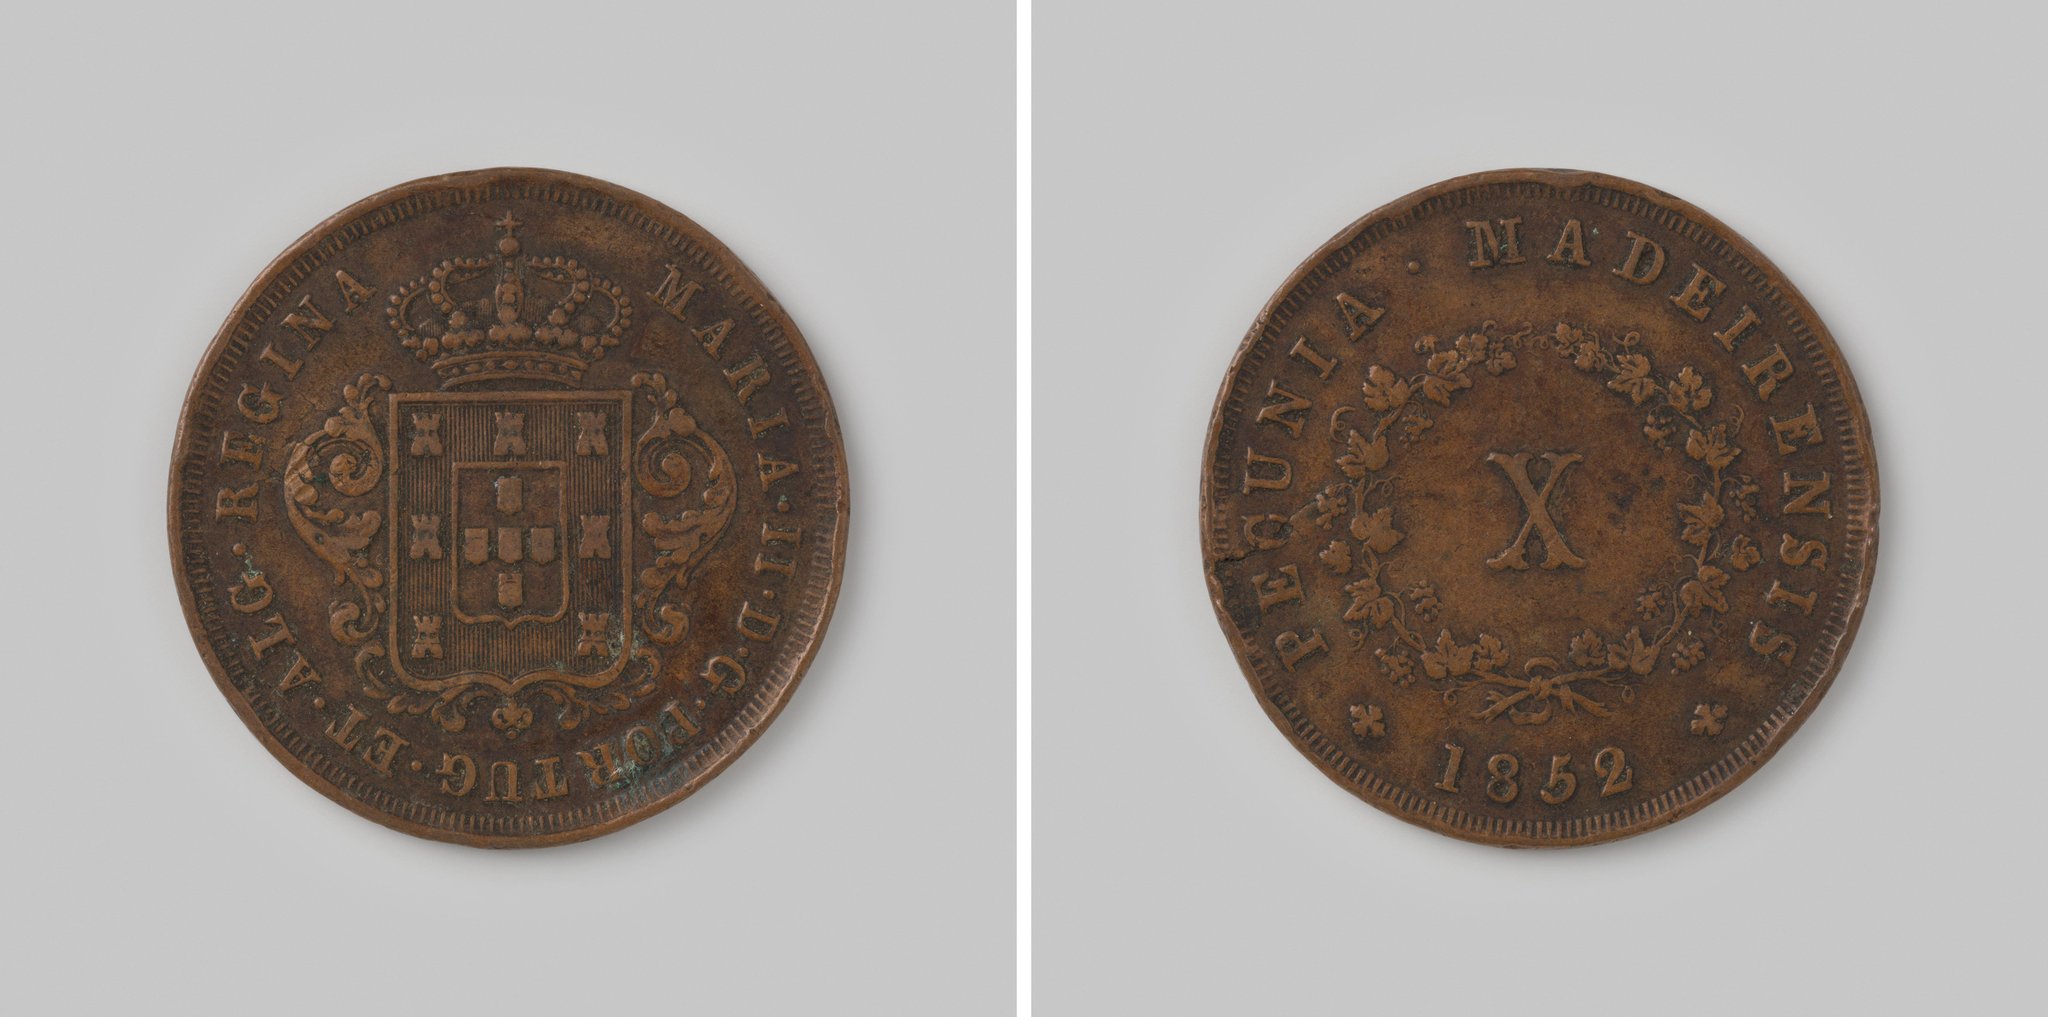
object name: coin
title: Madeira, koningin Maria II van Portugal, 10 reis, 1852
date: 1852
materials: copper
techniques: striking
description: Koperen munt. Voorzijde: versierd gekroond wapenschild van Portugal. Keerzijde: tussen twee samengebonden takken waarde-aanduiding: X. Omschrift: pecunia Madeirensis met jaartal onderaan. Gladde rand.